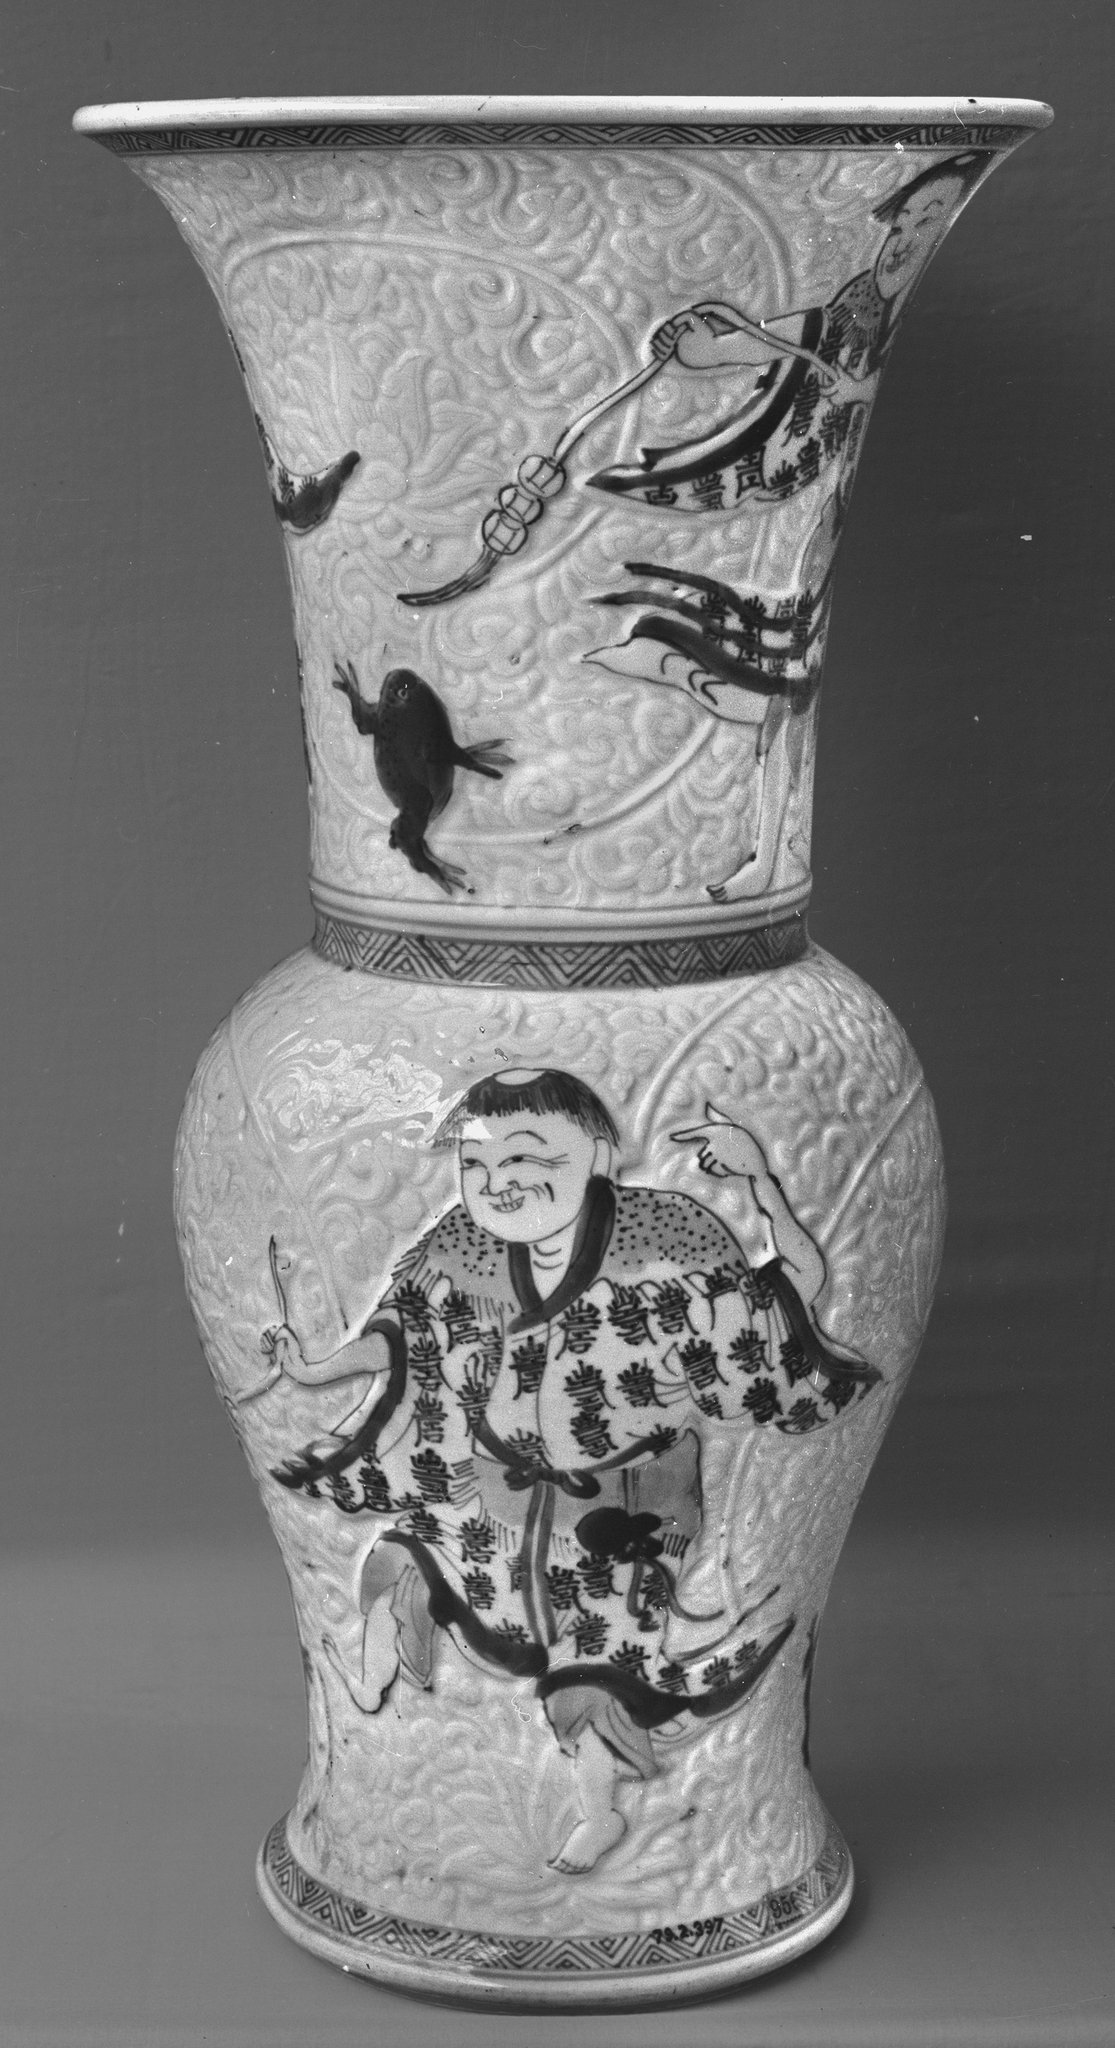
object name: vase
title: Vase with immortal Liu Hai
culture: chinese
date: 1701-1800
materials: cobalt, copper, porcelain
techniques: painting, relief, underglaze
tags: human figures